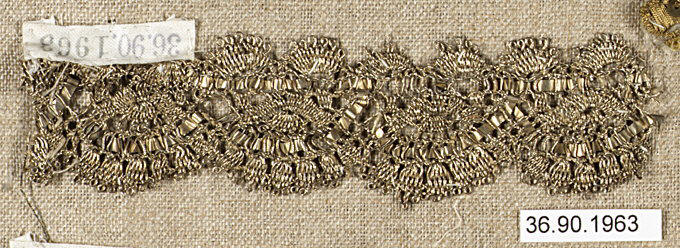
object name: piece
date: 1701-1800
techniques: lace